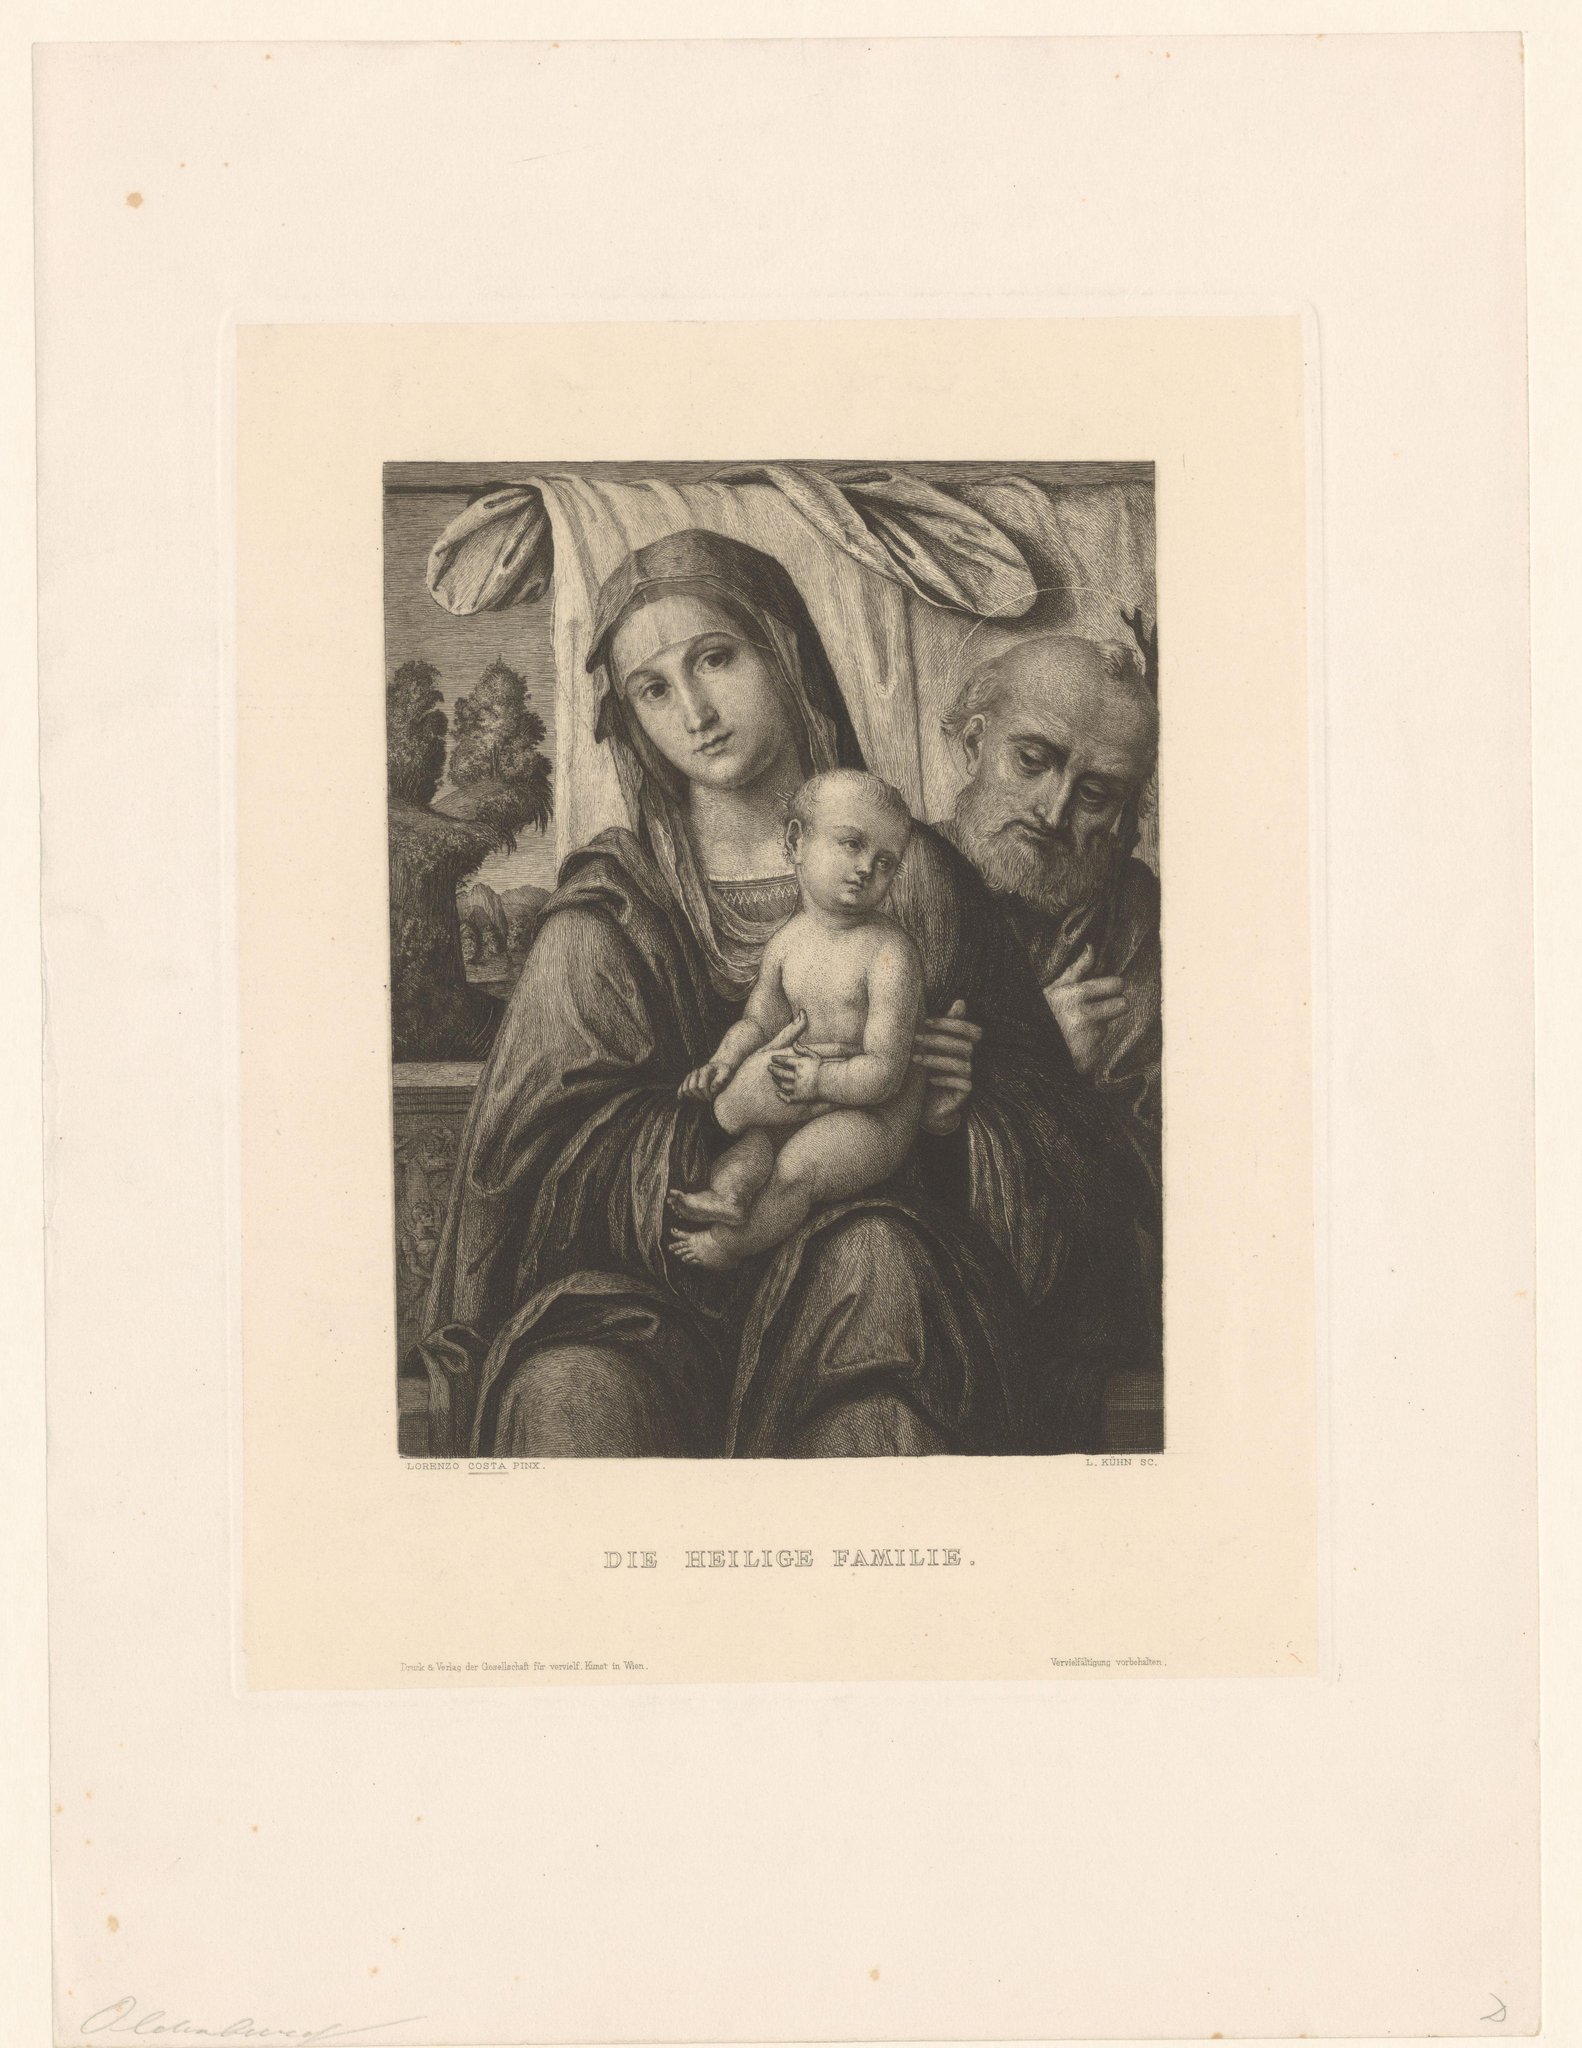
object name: print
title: Die heilige Familie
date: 1871-1934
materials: paper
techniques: engraving, etching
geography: vienna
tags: holy family, and derived representations, stay of the holy family in egypt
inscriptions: collector's mark: Lugt 2228